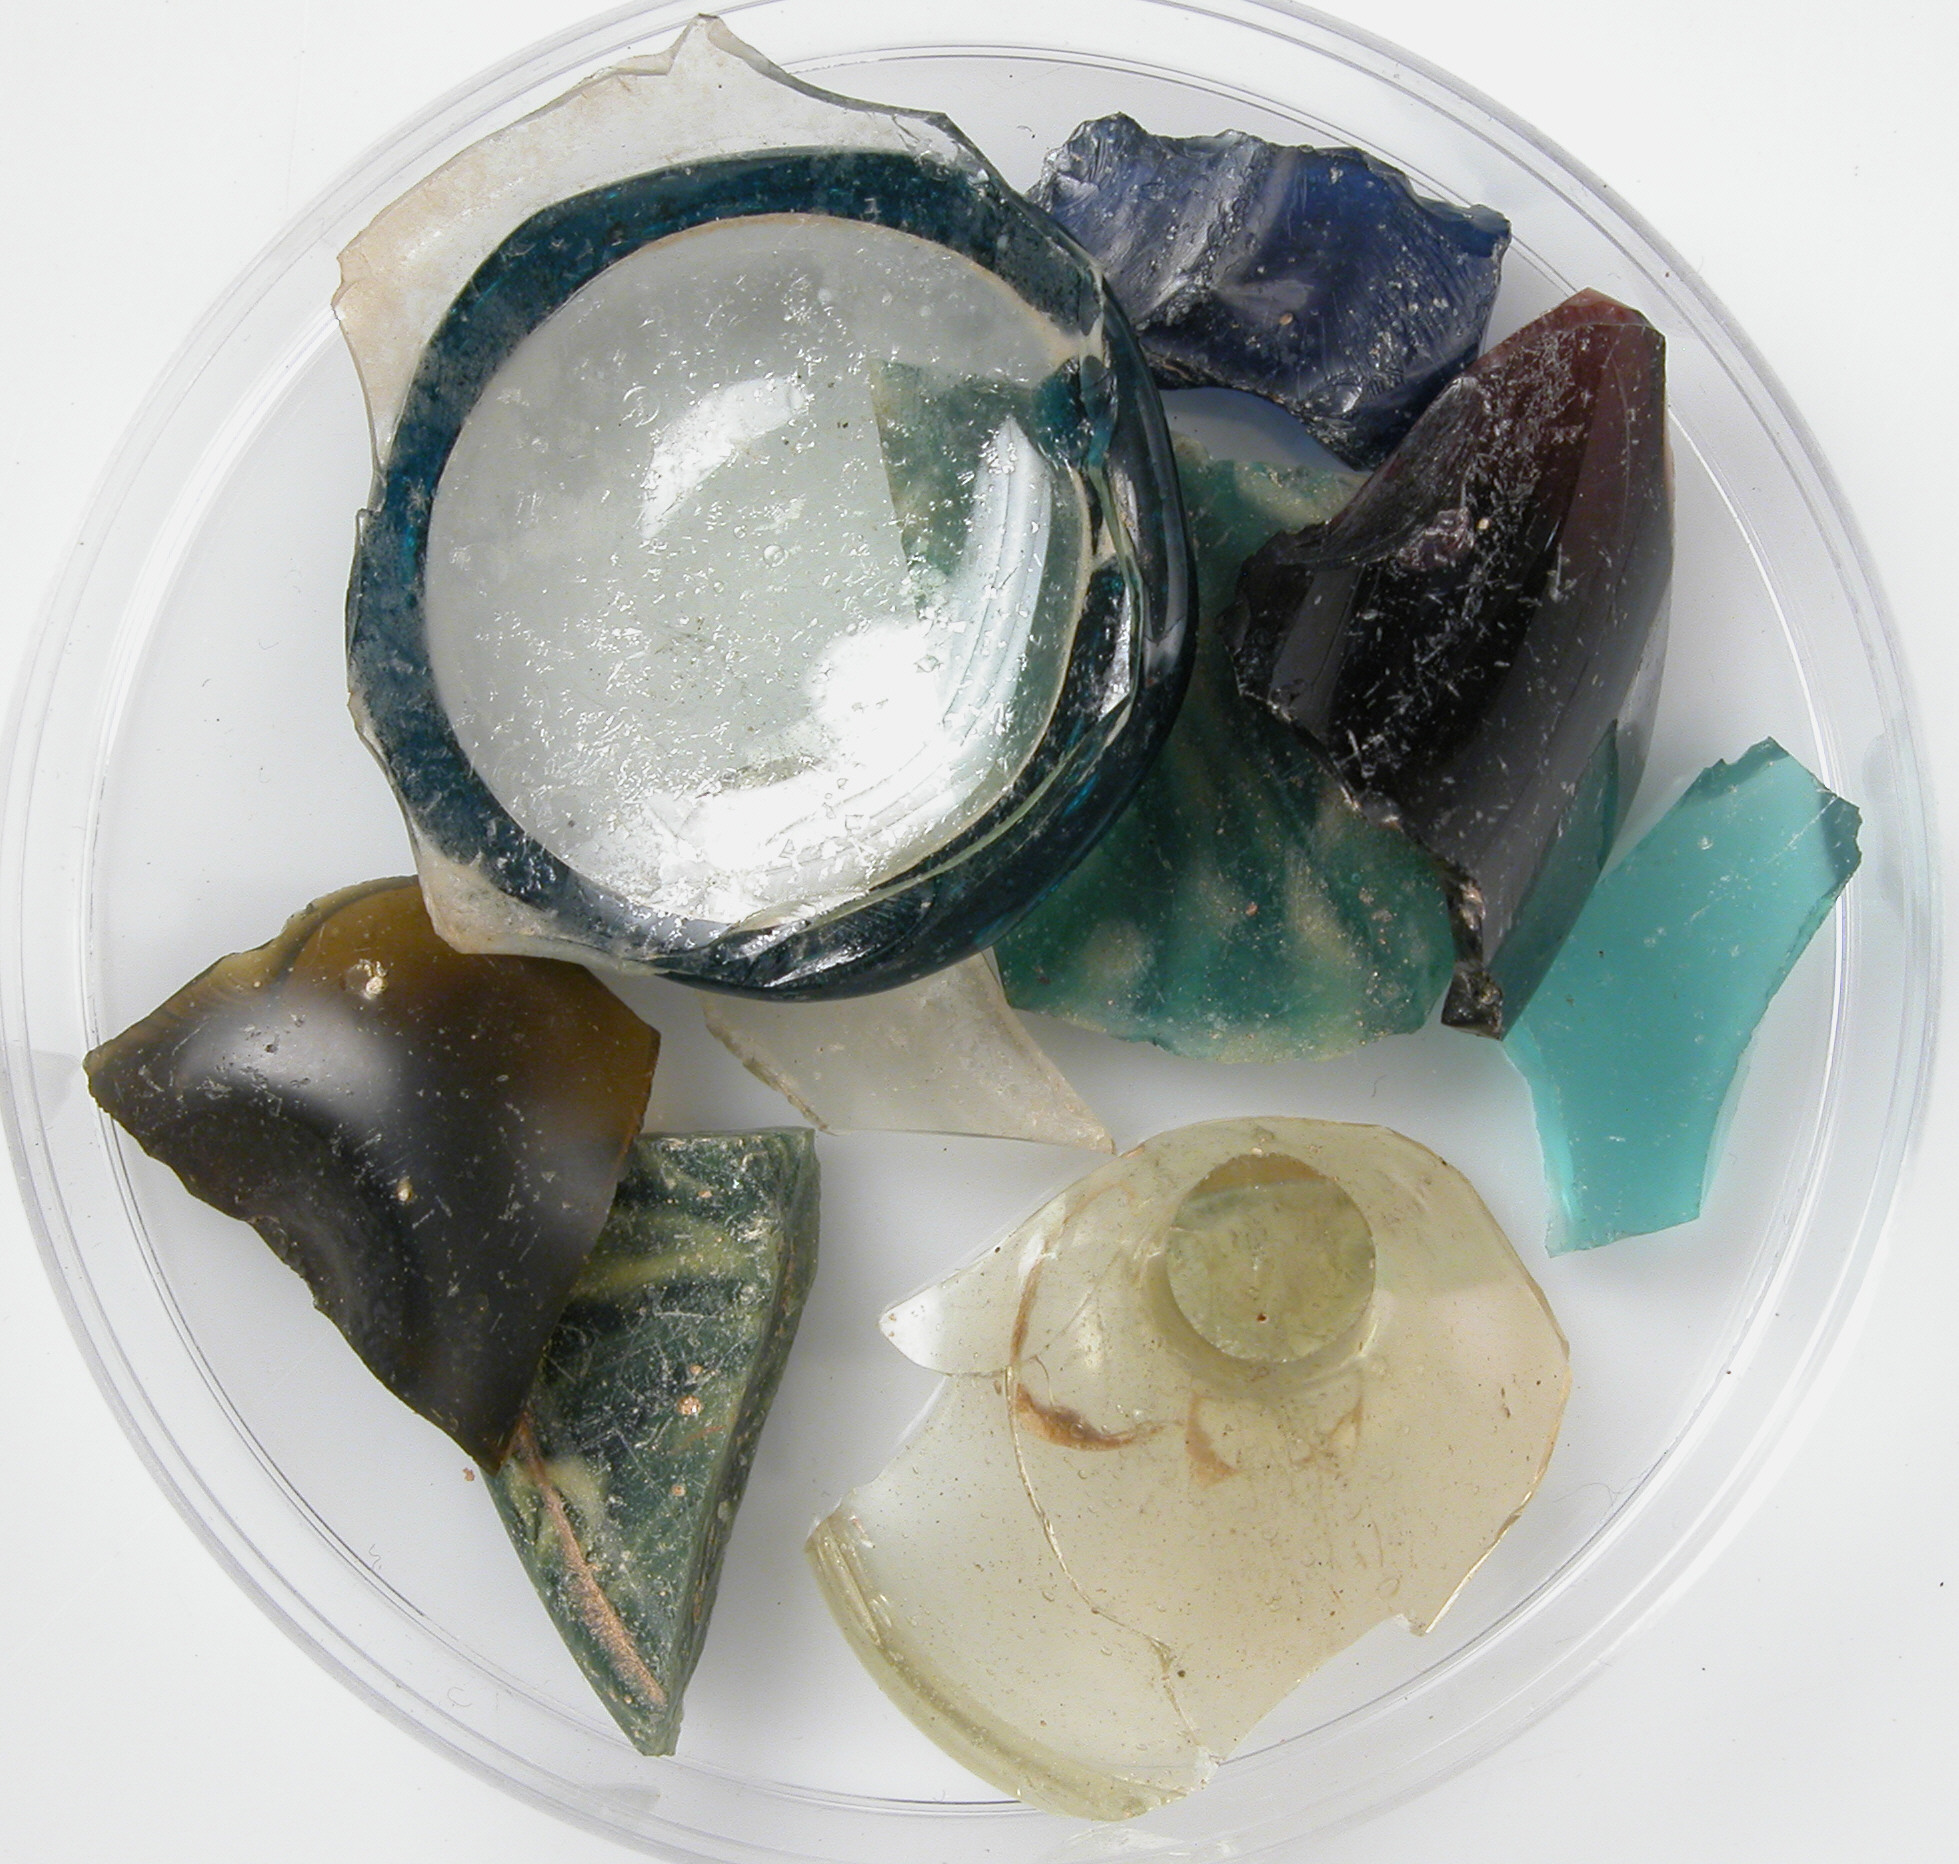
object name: fragment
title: Glass Fragments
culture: coptic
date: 301-700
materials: glass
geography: egypt